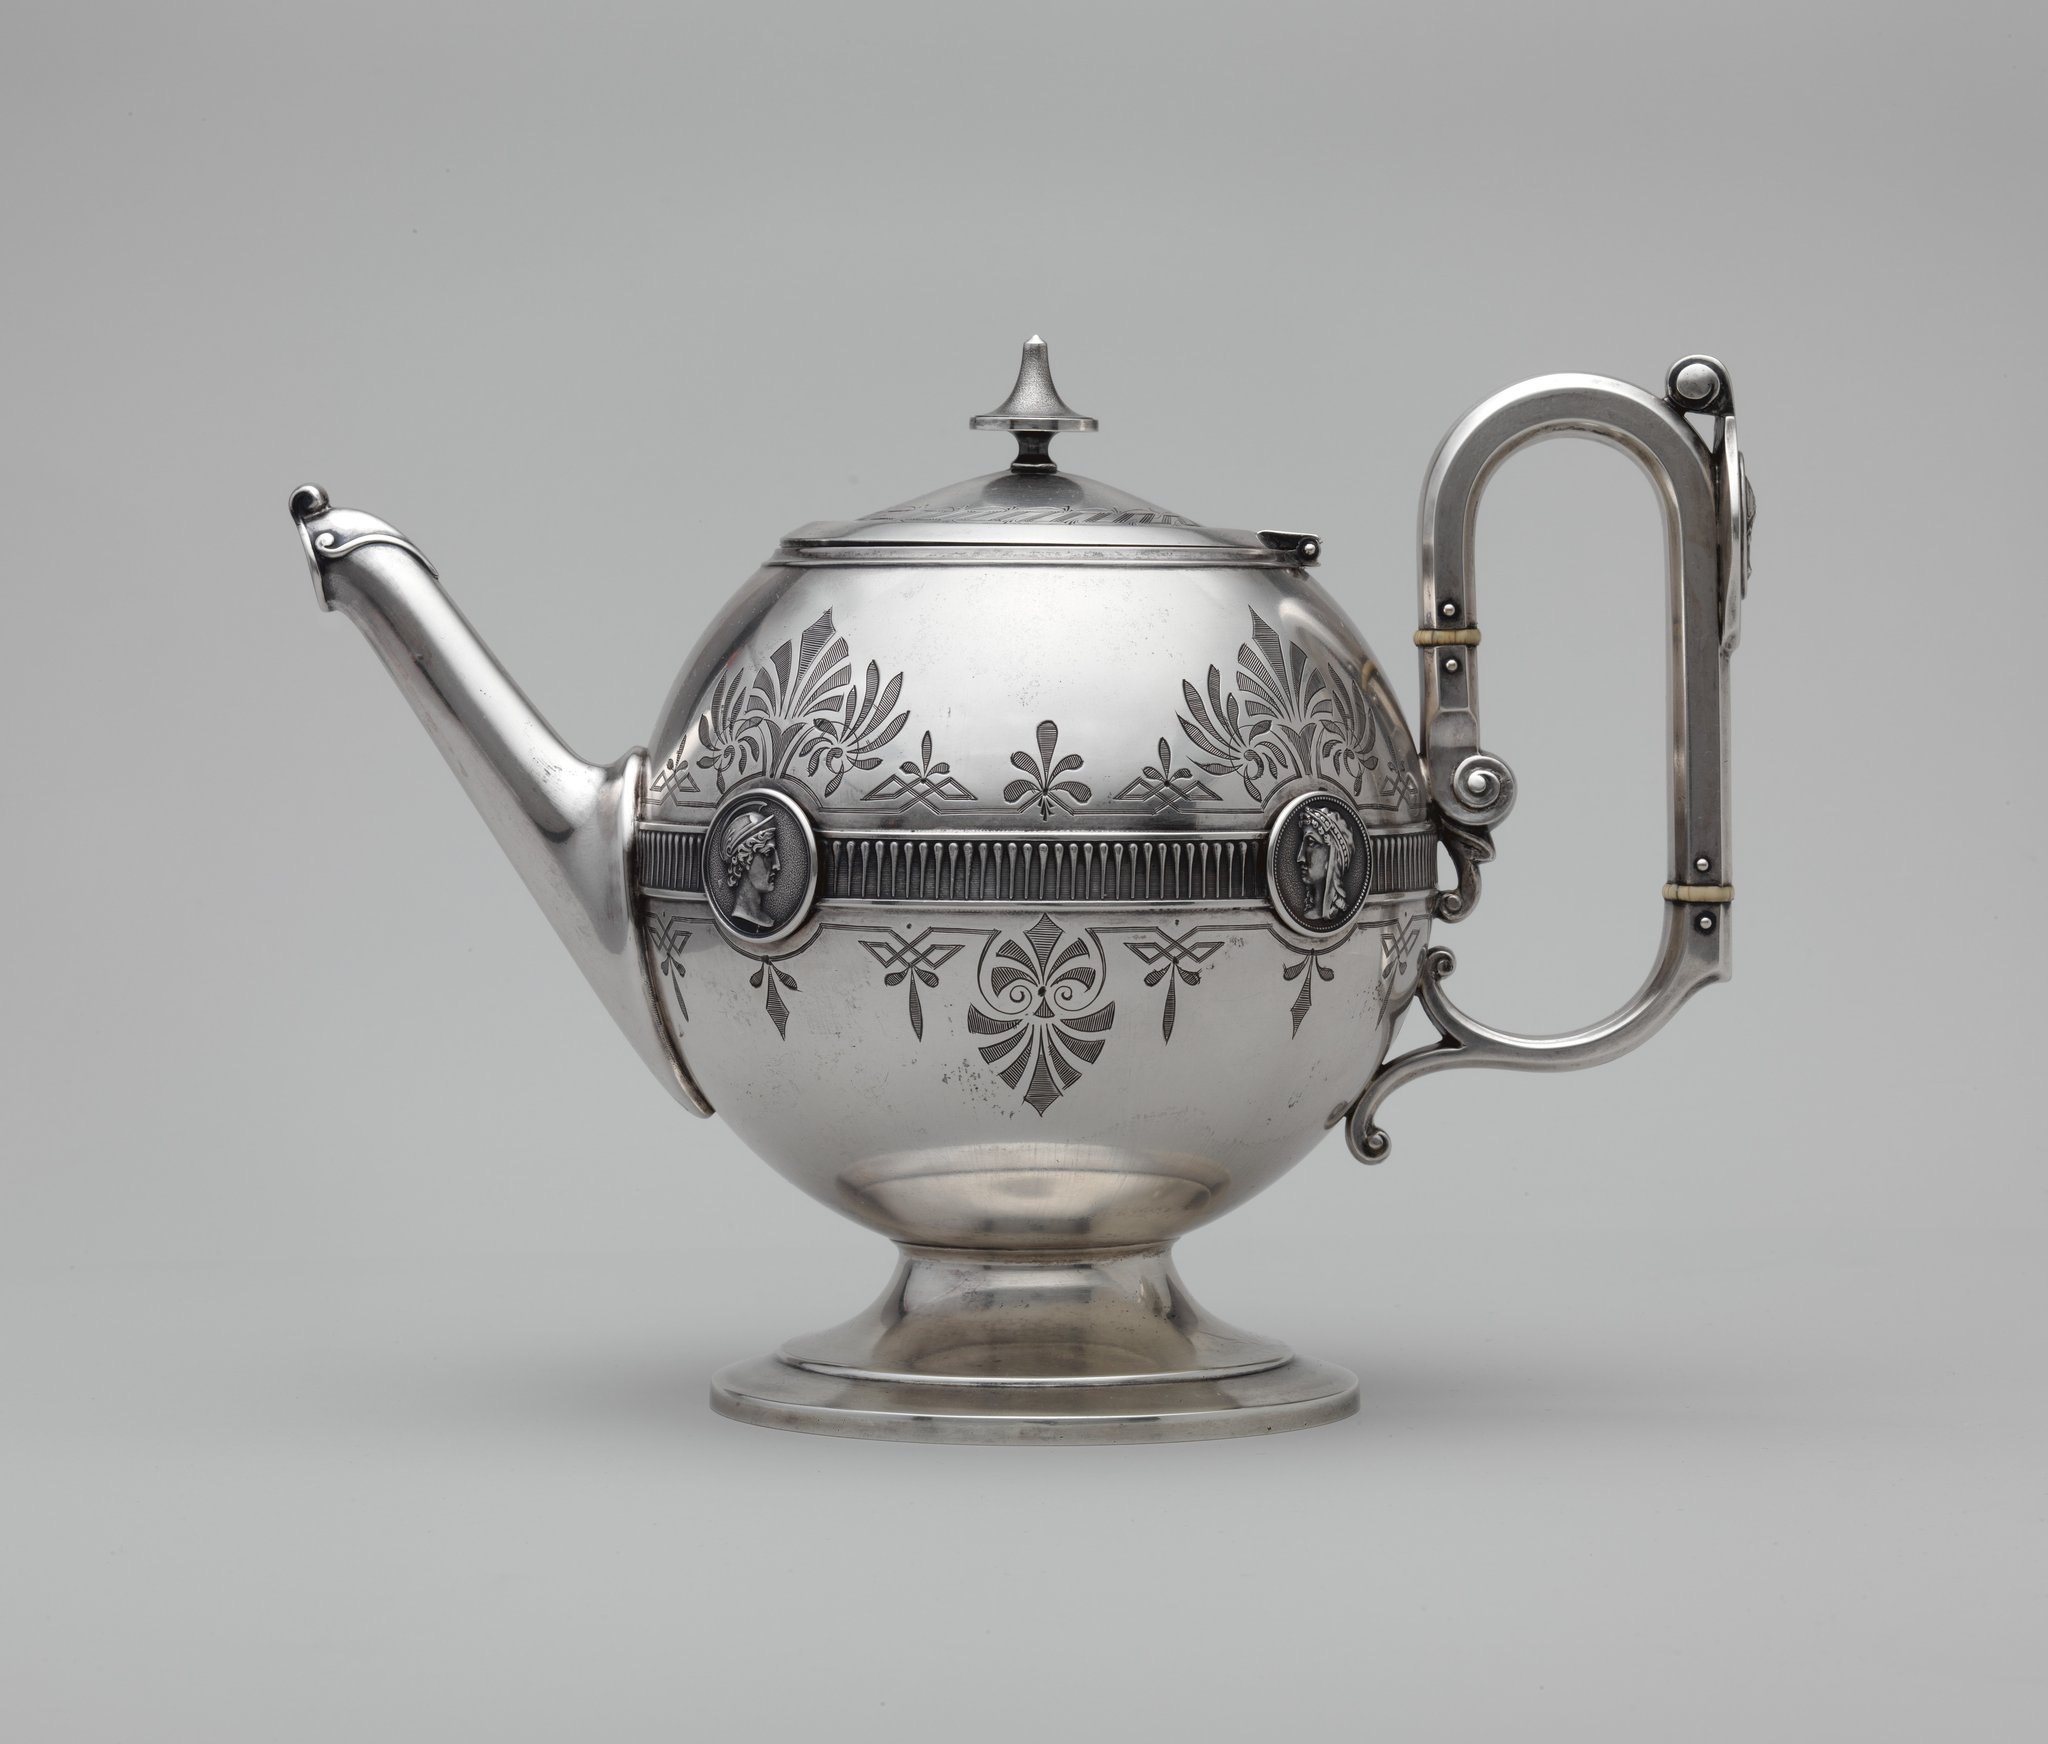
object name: teapot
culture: american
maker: gorham manufacturing company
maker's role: maker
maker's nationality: american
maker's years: 1831-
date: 1865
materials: ivory, silver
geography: united states